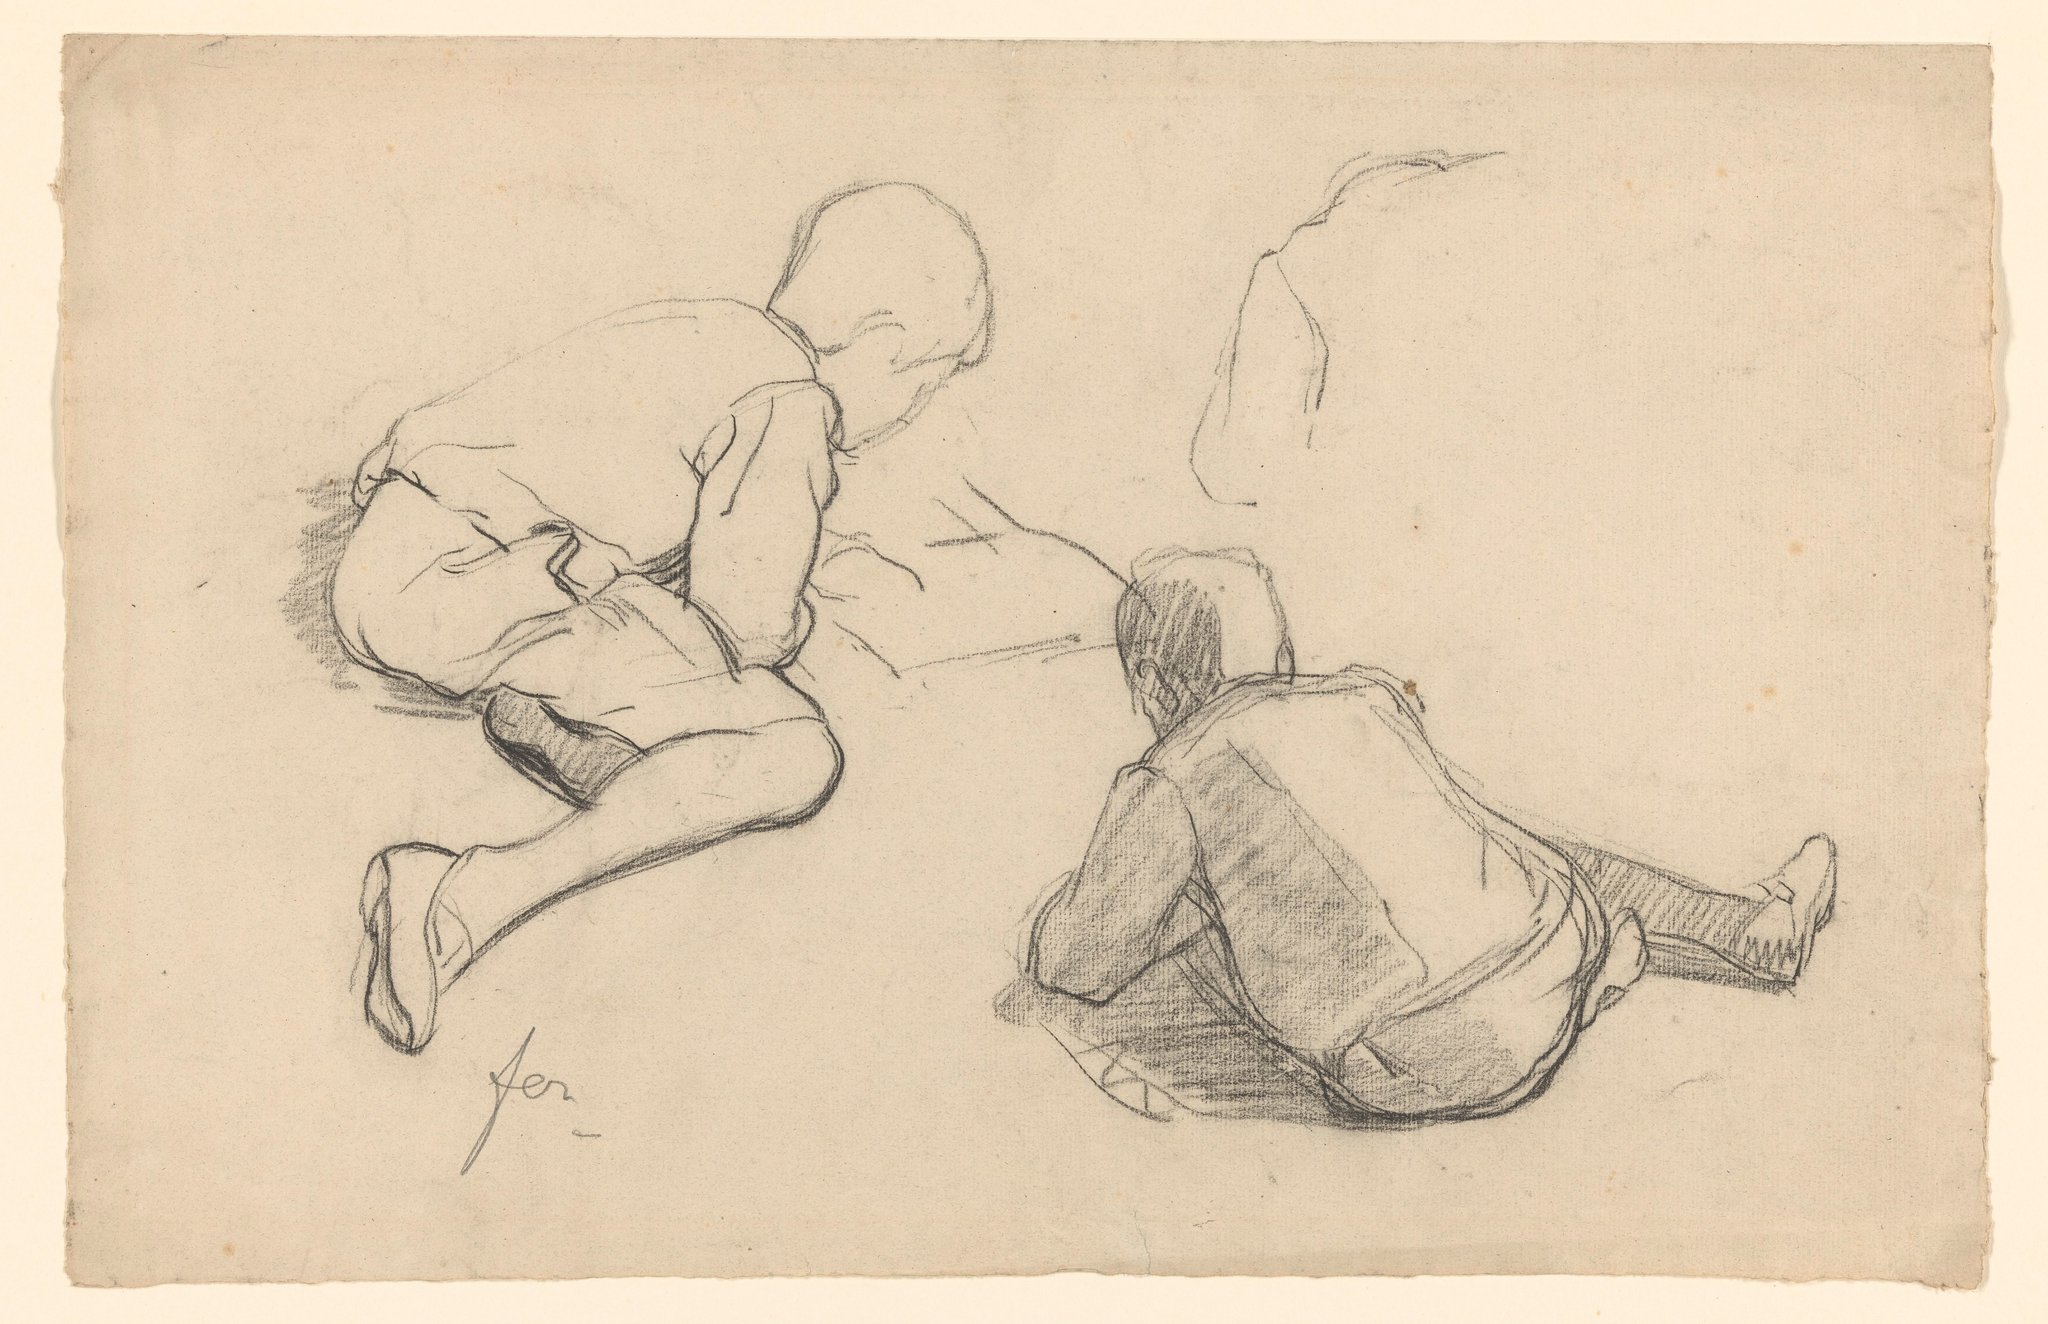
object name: drawing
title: Twee studies van een op de grond lezende jongen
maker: ferdinand oldewelt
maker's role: draughtsman, print maker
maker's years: 1857-1935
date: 1867-1935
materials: chalk, paper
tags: reading